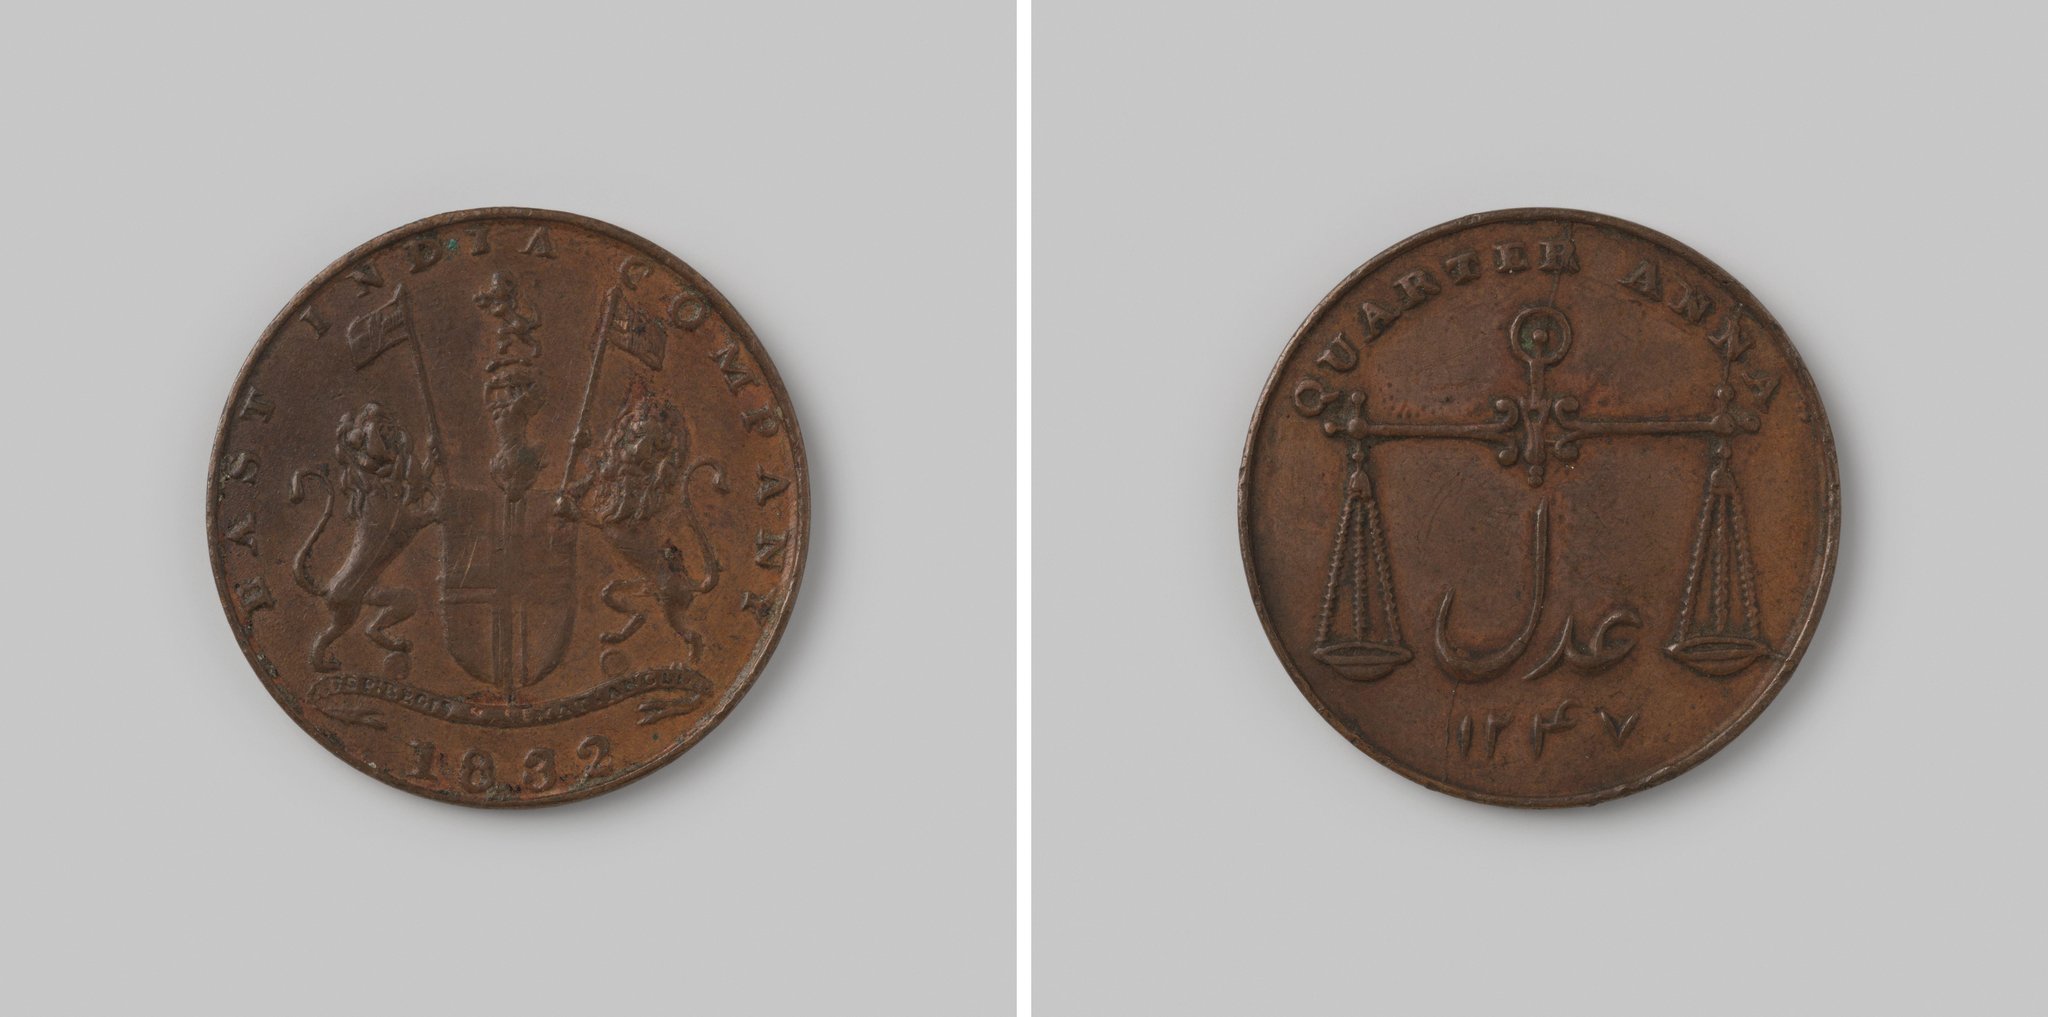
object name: coin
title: 1/4 anna voor Bombay in India van de Engelse Oostindische Compagnie (EIC), 1832, 1247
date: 1832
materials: copper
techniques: striking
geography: mumbai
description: Koperen munt. Voorzijde: door twee op banderol, waarin opschrift, staande leeuwen met pijl, waaraan vlag, in de klauw, gehouden wapenschild van de EIC, waarboven helmteken. Jaartal onderaan. Keerzijde: weegschaal, waartussen in Arabische lettertekens opschrift: Adil. Bovenaan waarde-aanduiding: quarter anna en en onderaan jaartal: 1247. Gladde rand.